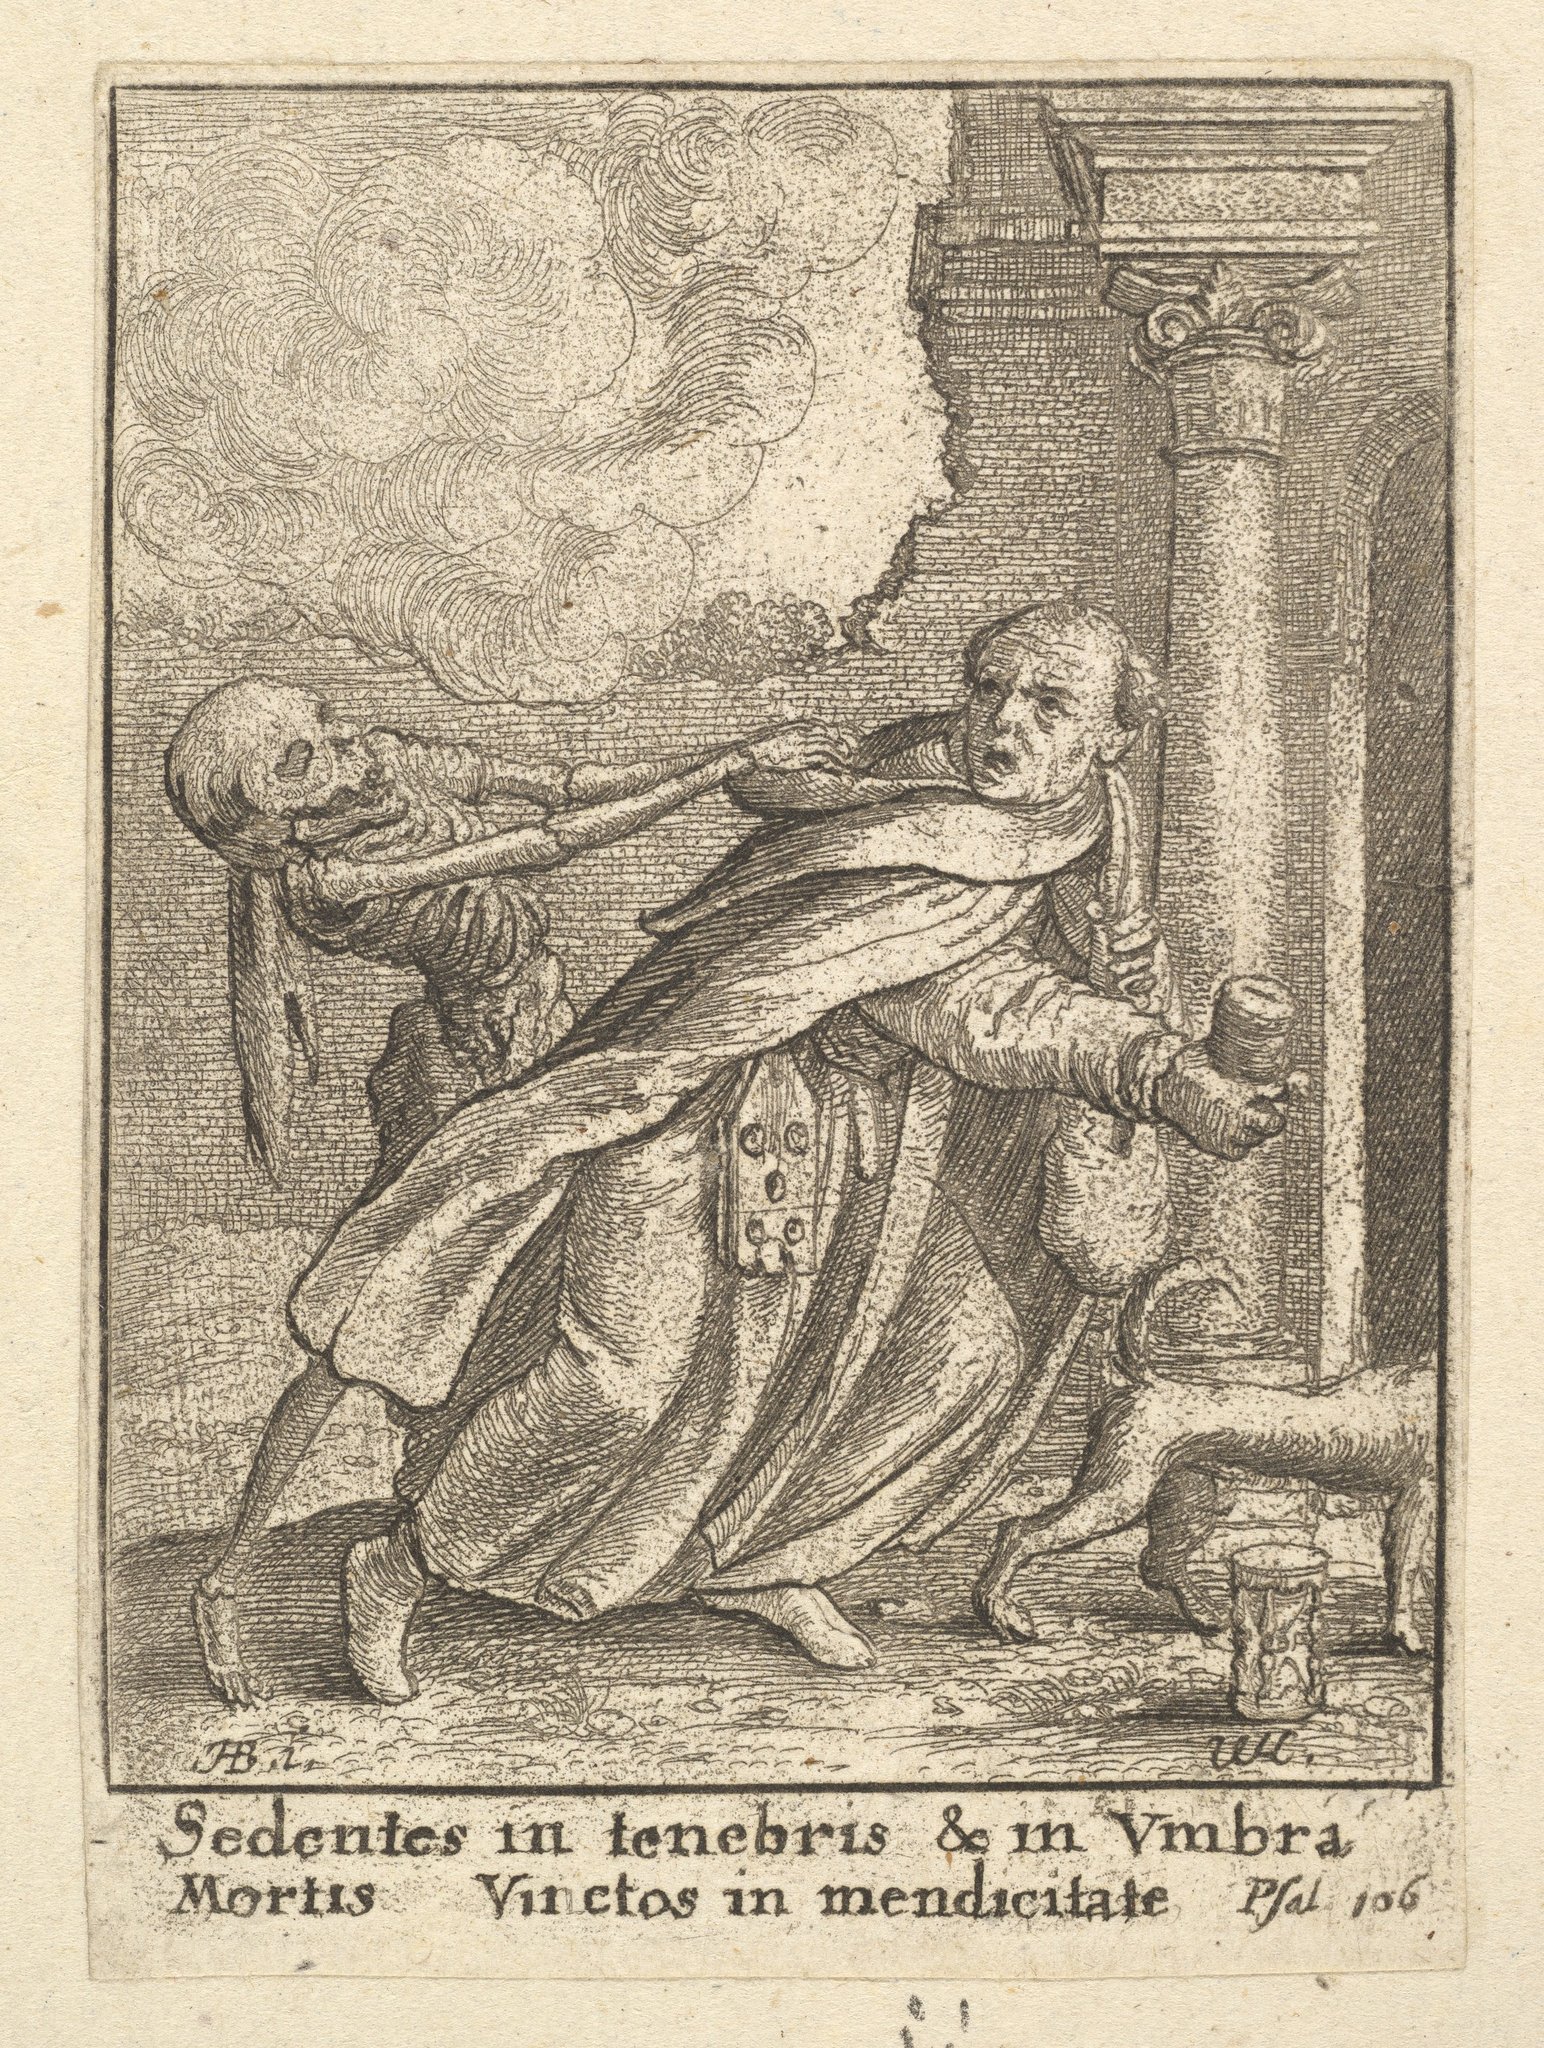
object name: print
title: The Monk, from the Dance of Death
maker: wenceslaus hollar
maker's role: artist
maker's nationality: bohemian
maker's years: 1607-1677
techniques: etching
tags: skeletons,dogs,monks